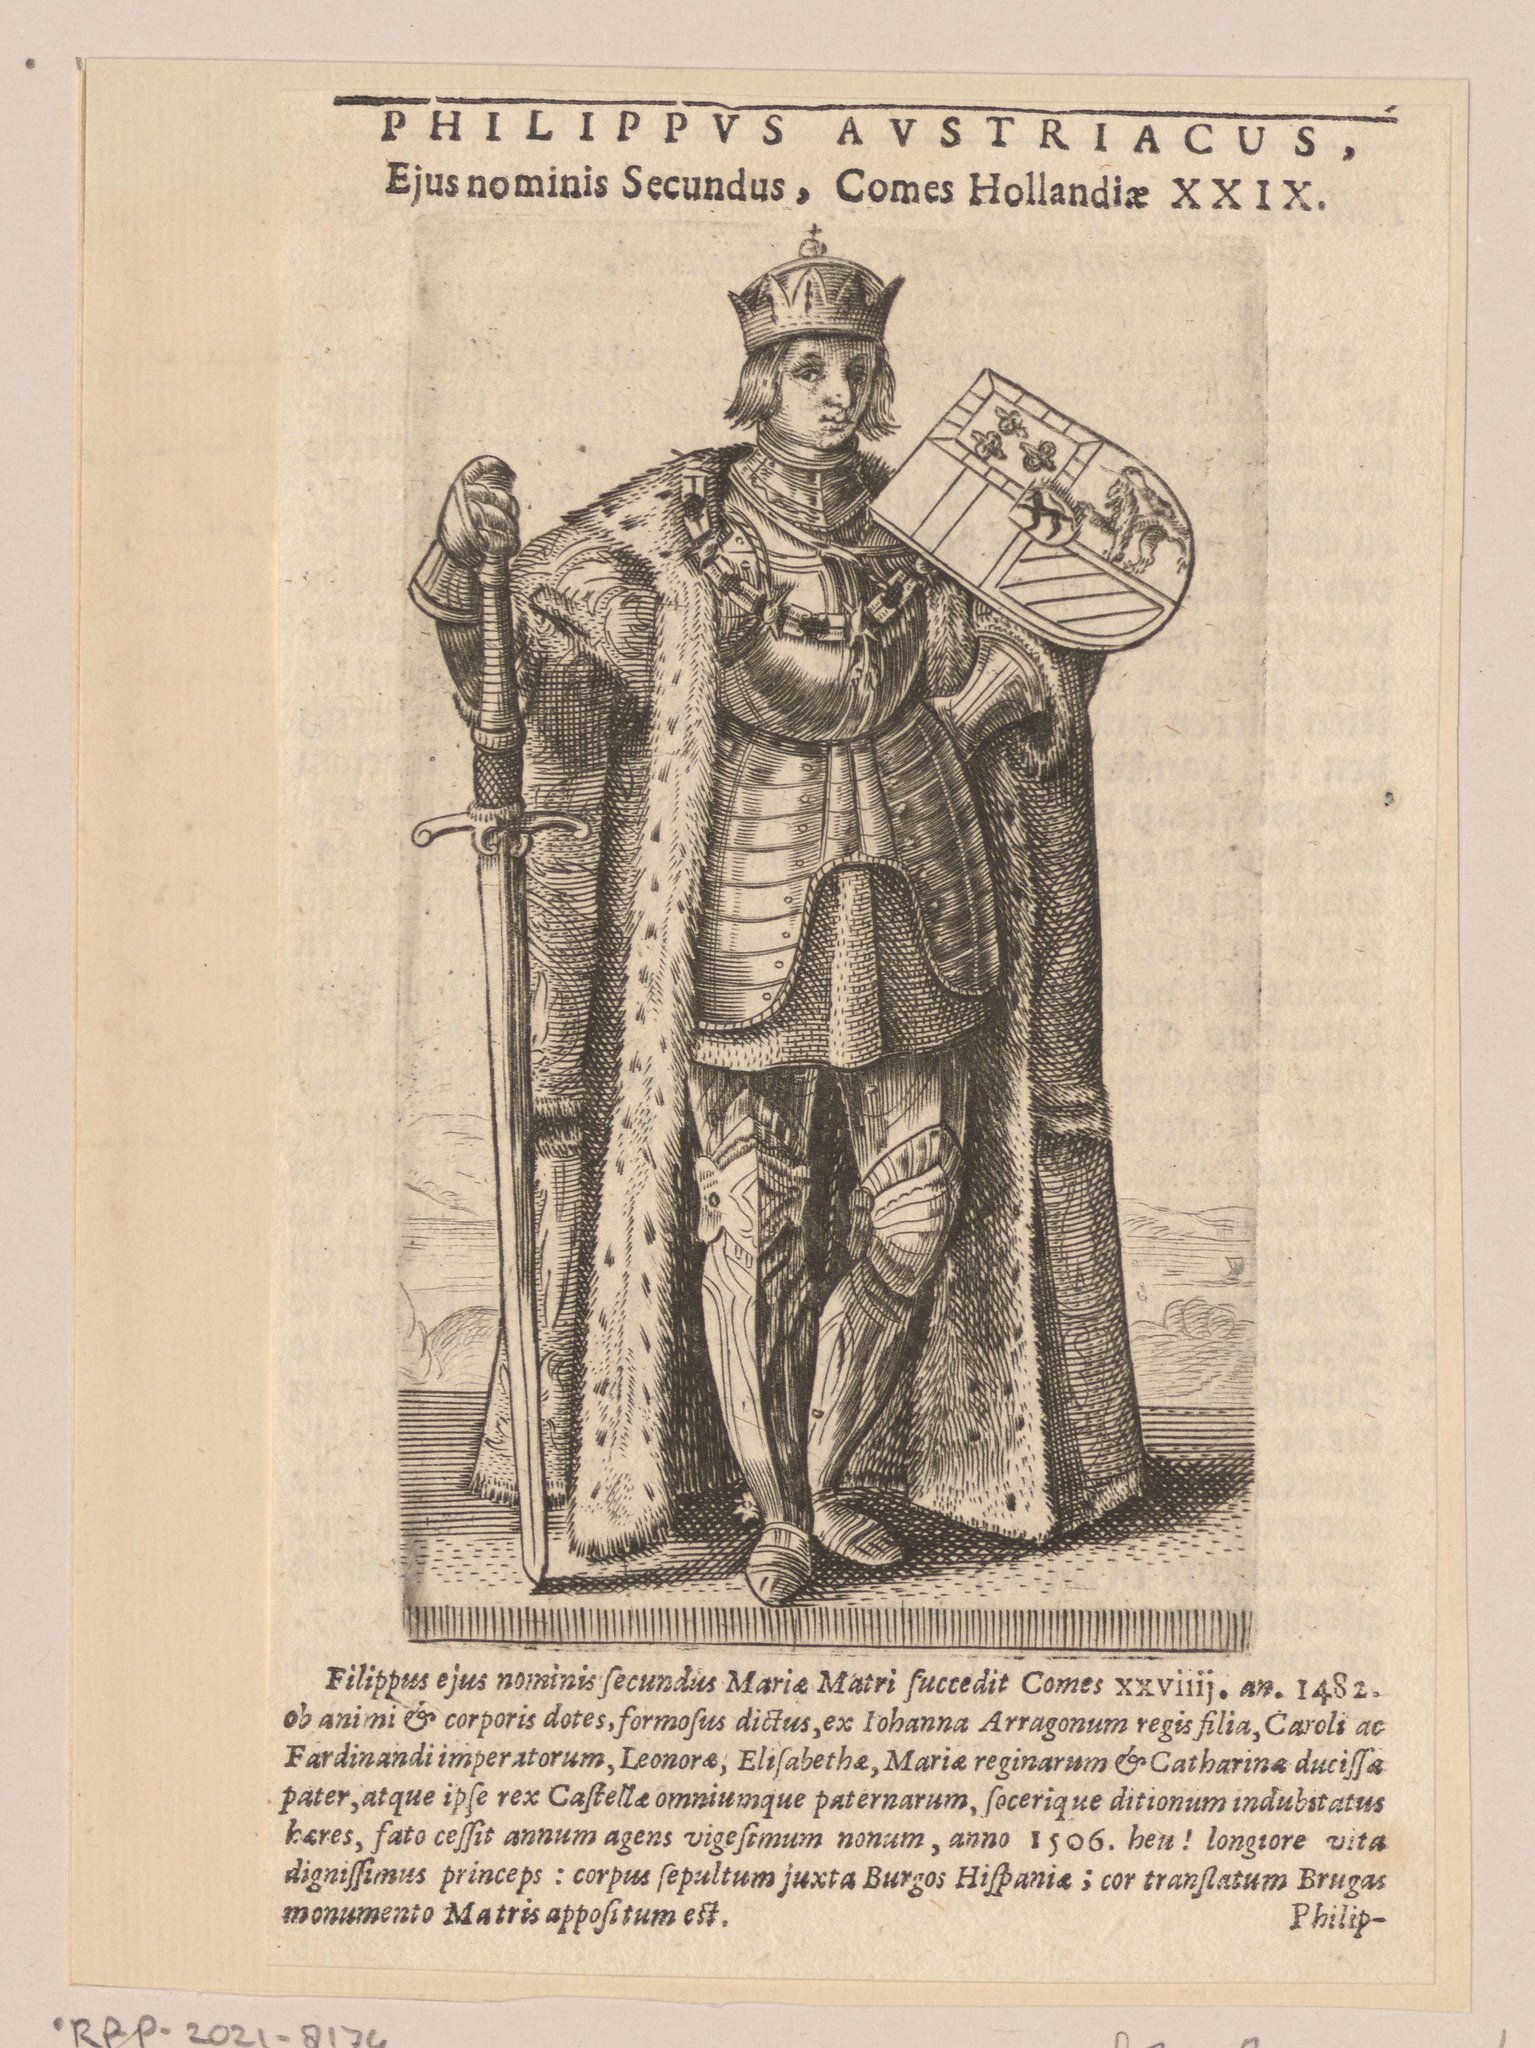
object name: book illustration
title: Portret van Filips de Schone, hertog van Bourgondië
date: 1663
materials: paper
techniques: engraving, letterpress printing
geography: haarlem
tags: bruges, filips de schone (hertog van bourgondië), armour, historical persons, knighthood order of the golden fleece, armorial bearing, heraldry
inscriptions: inscription: ‘De Aarts-Hertog (...) vorsten af.’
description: Prent uit: Het oude Goutsche chronycxken van Hollandt, Zeelandt, Vrieslandt en Utrecht. Amsterdam: Jan Hendricksz. Boom, Joost Pluymer and Casparus Commelin, 1663. Prent maakt ook onderdeel uit van een serie met graven en gravinnen van Holland.